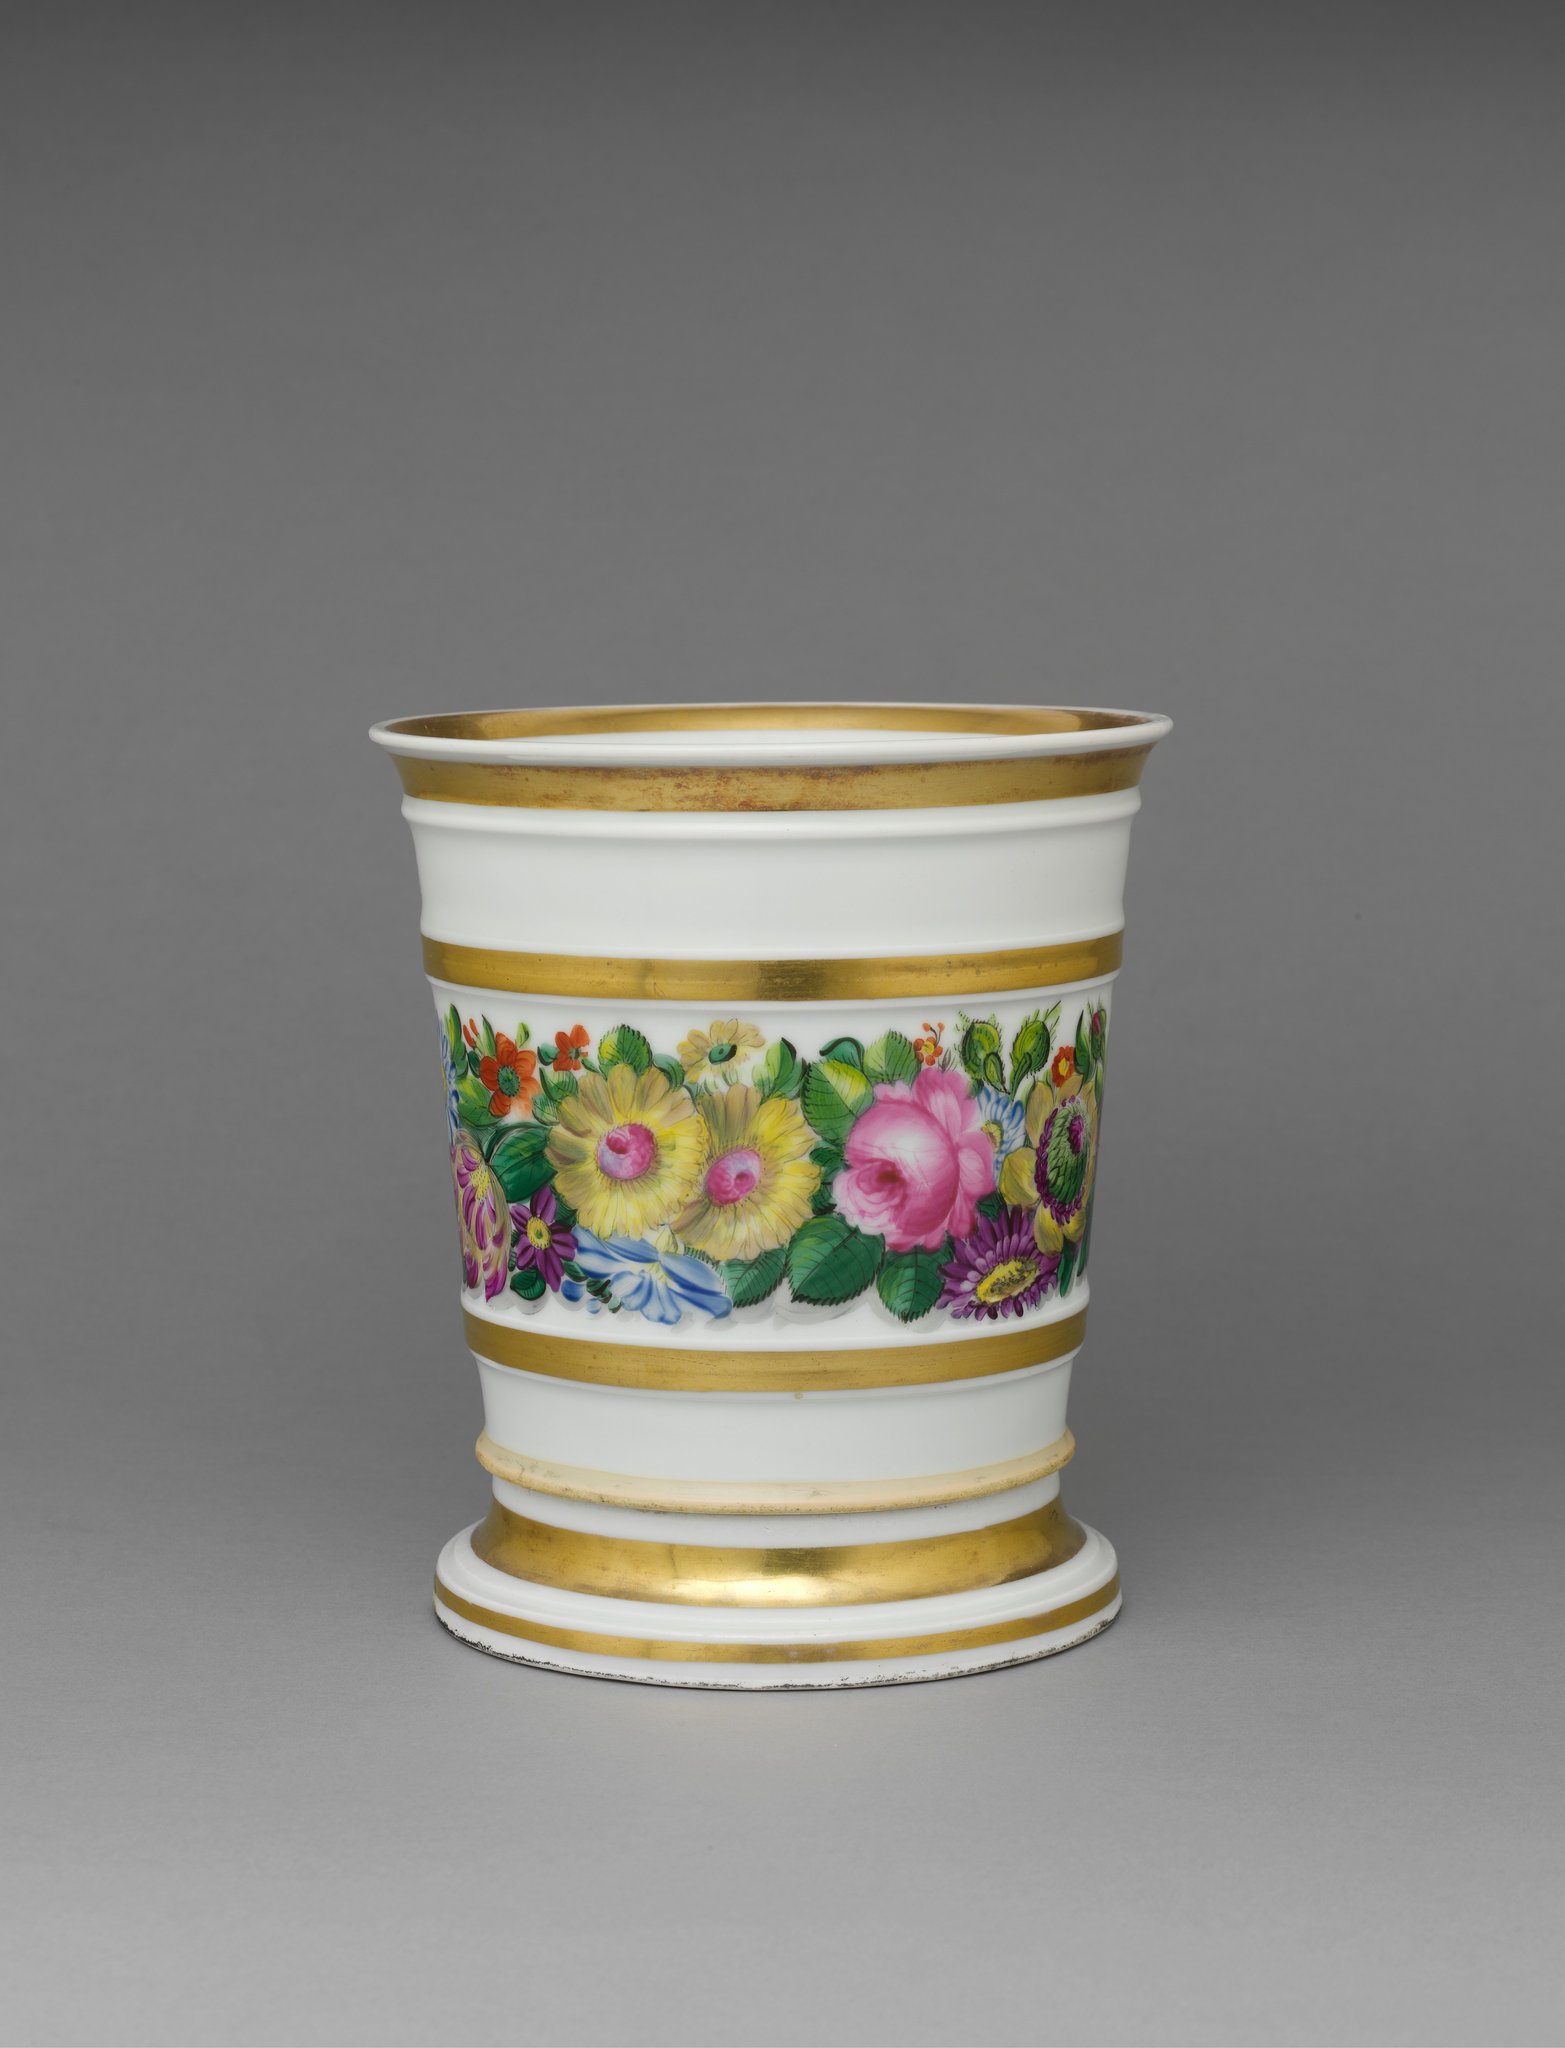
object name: flowerpot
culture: american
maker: tucker factory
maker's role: manufacturer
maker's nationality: american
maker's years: 1826-1838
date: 1827-1838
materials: porcelain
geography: united states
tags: flowers